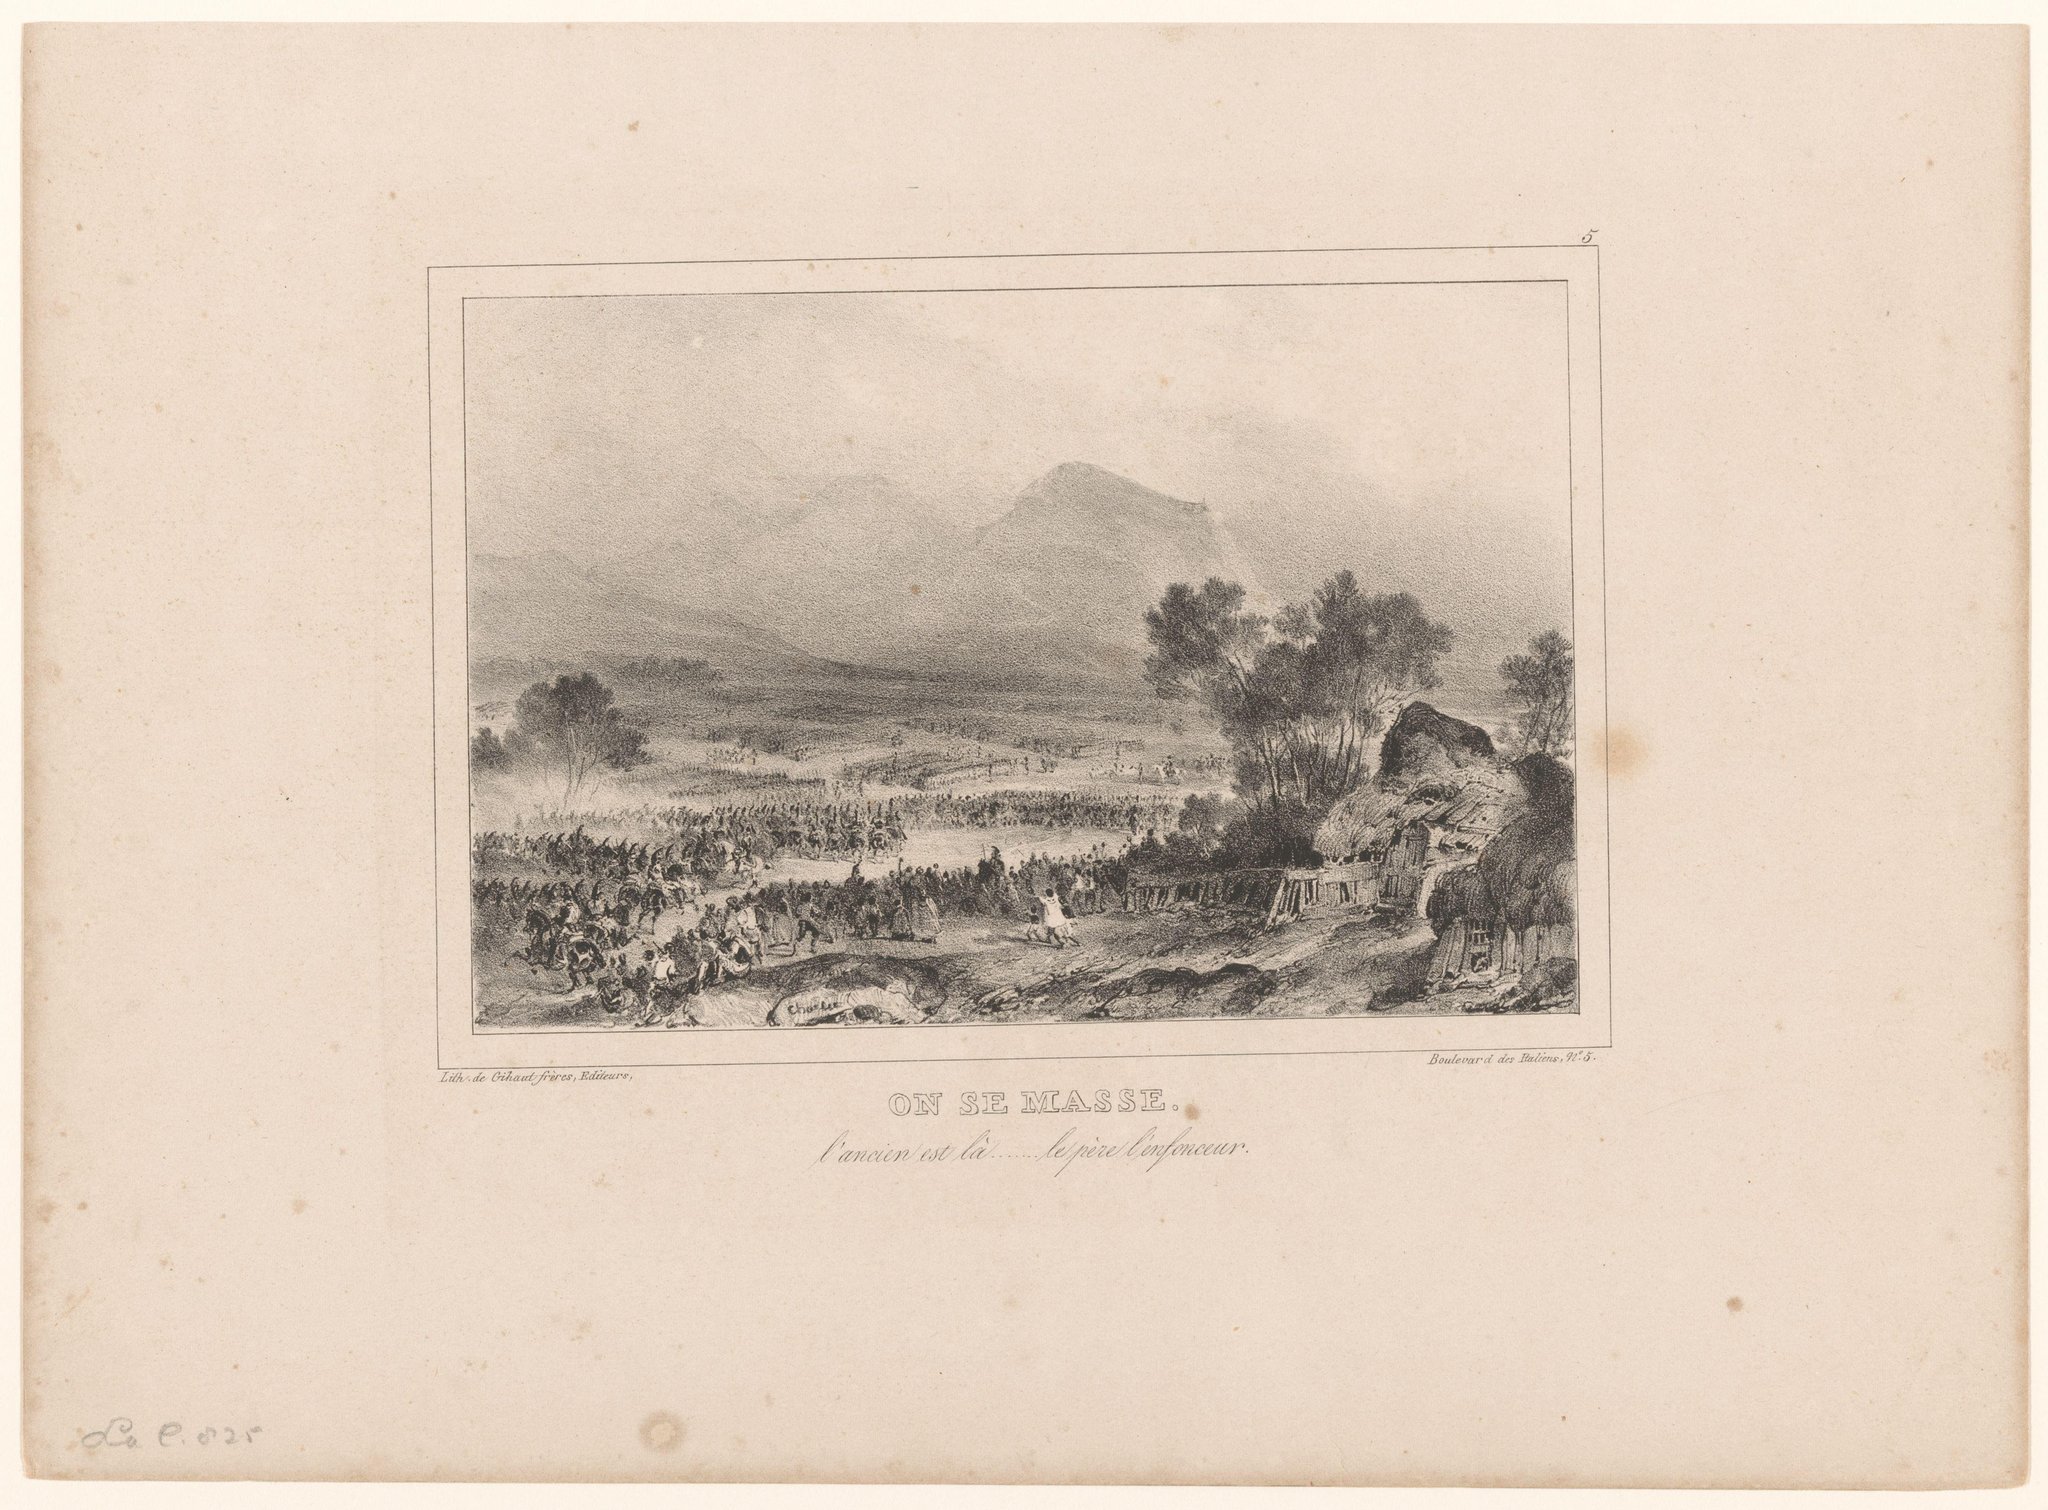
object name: print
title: Lithografisch album 1834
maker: nicolas toussaint charlet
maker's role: draughtsman, painter, print maker, printer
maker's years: 1792-1845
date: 1834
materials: paper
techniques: lithograph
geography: paris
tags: napoleon i (emperor of the french), dale, valley, land forces, homage to a ruler, mountains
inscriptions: collector's mark: Lugt 2228a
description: Dorpelingen drommen samen in een vallei om de troepen van Napoleon te zien, en een glimp van de aanvoerder zelf op te vangen.